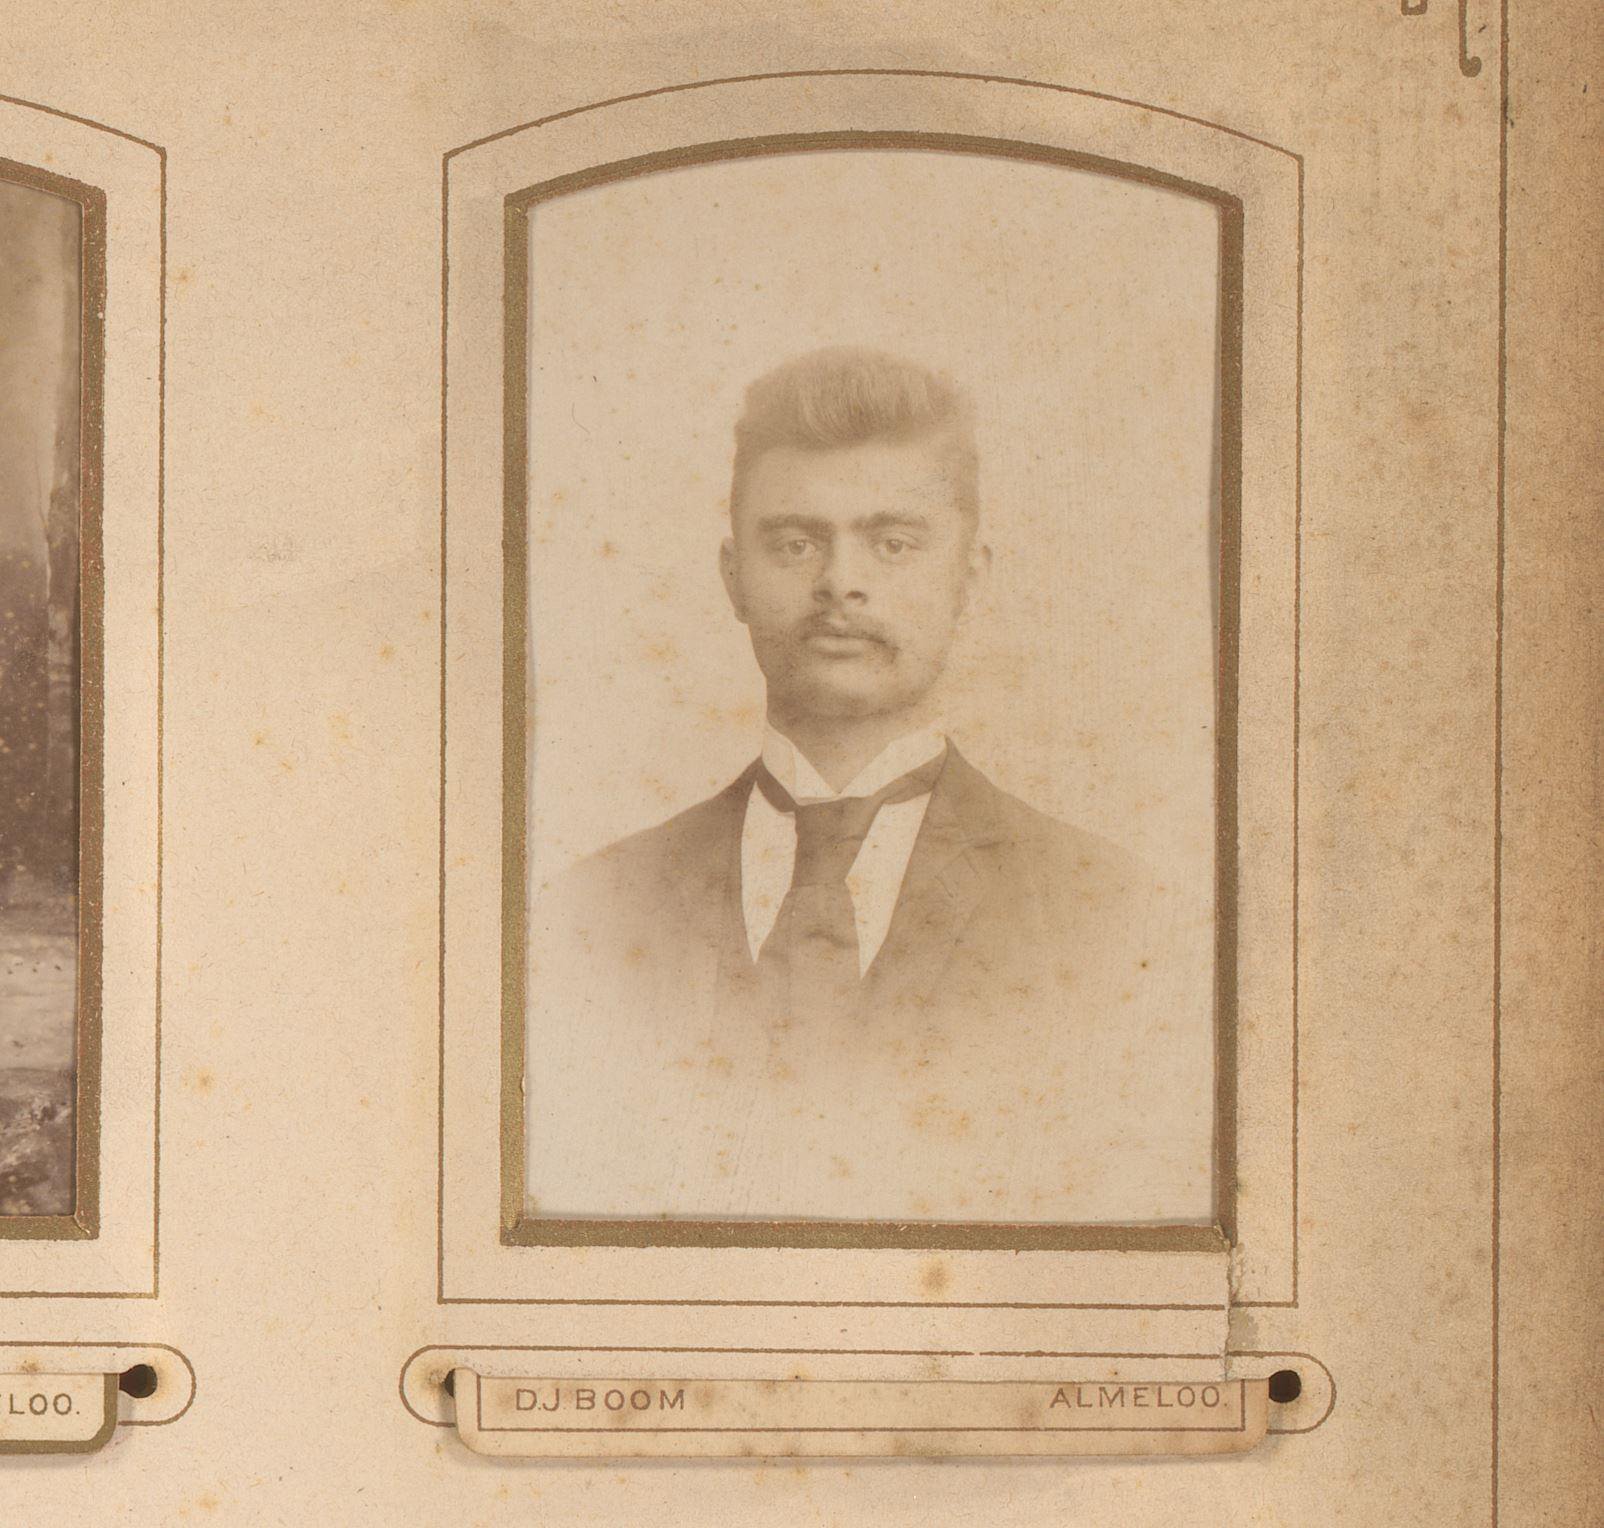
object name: photograph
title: Portret van een jongeman met snor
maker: derk jan boom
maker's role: draughtsman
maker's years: 1853-1935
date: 1888-1905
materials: cardboard, photographic support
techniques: albumen print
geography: almelo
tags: moustache, historical persons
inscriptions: inscription: ‘D.J. Boom/ Photograaf/ Portretteekenaar/ Almeloo’